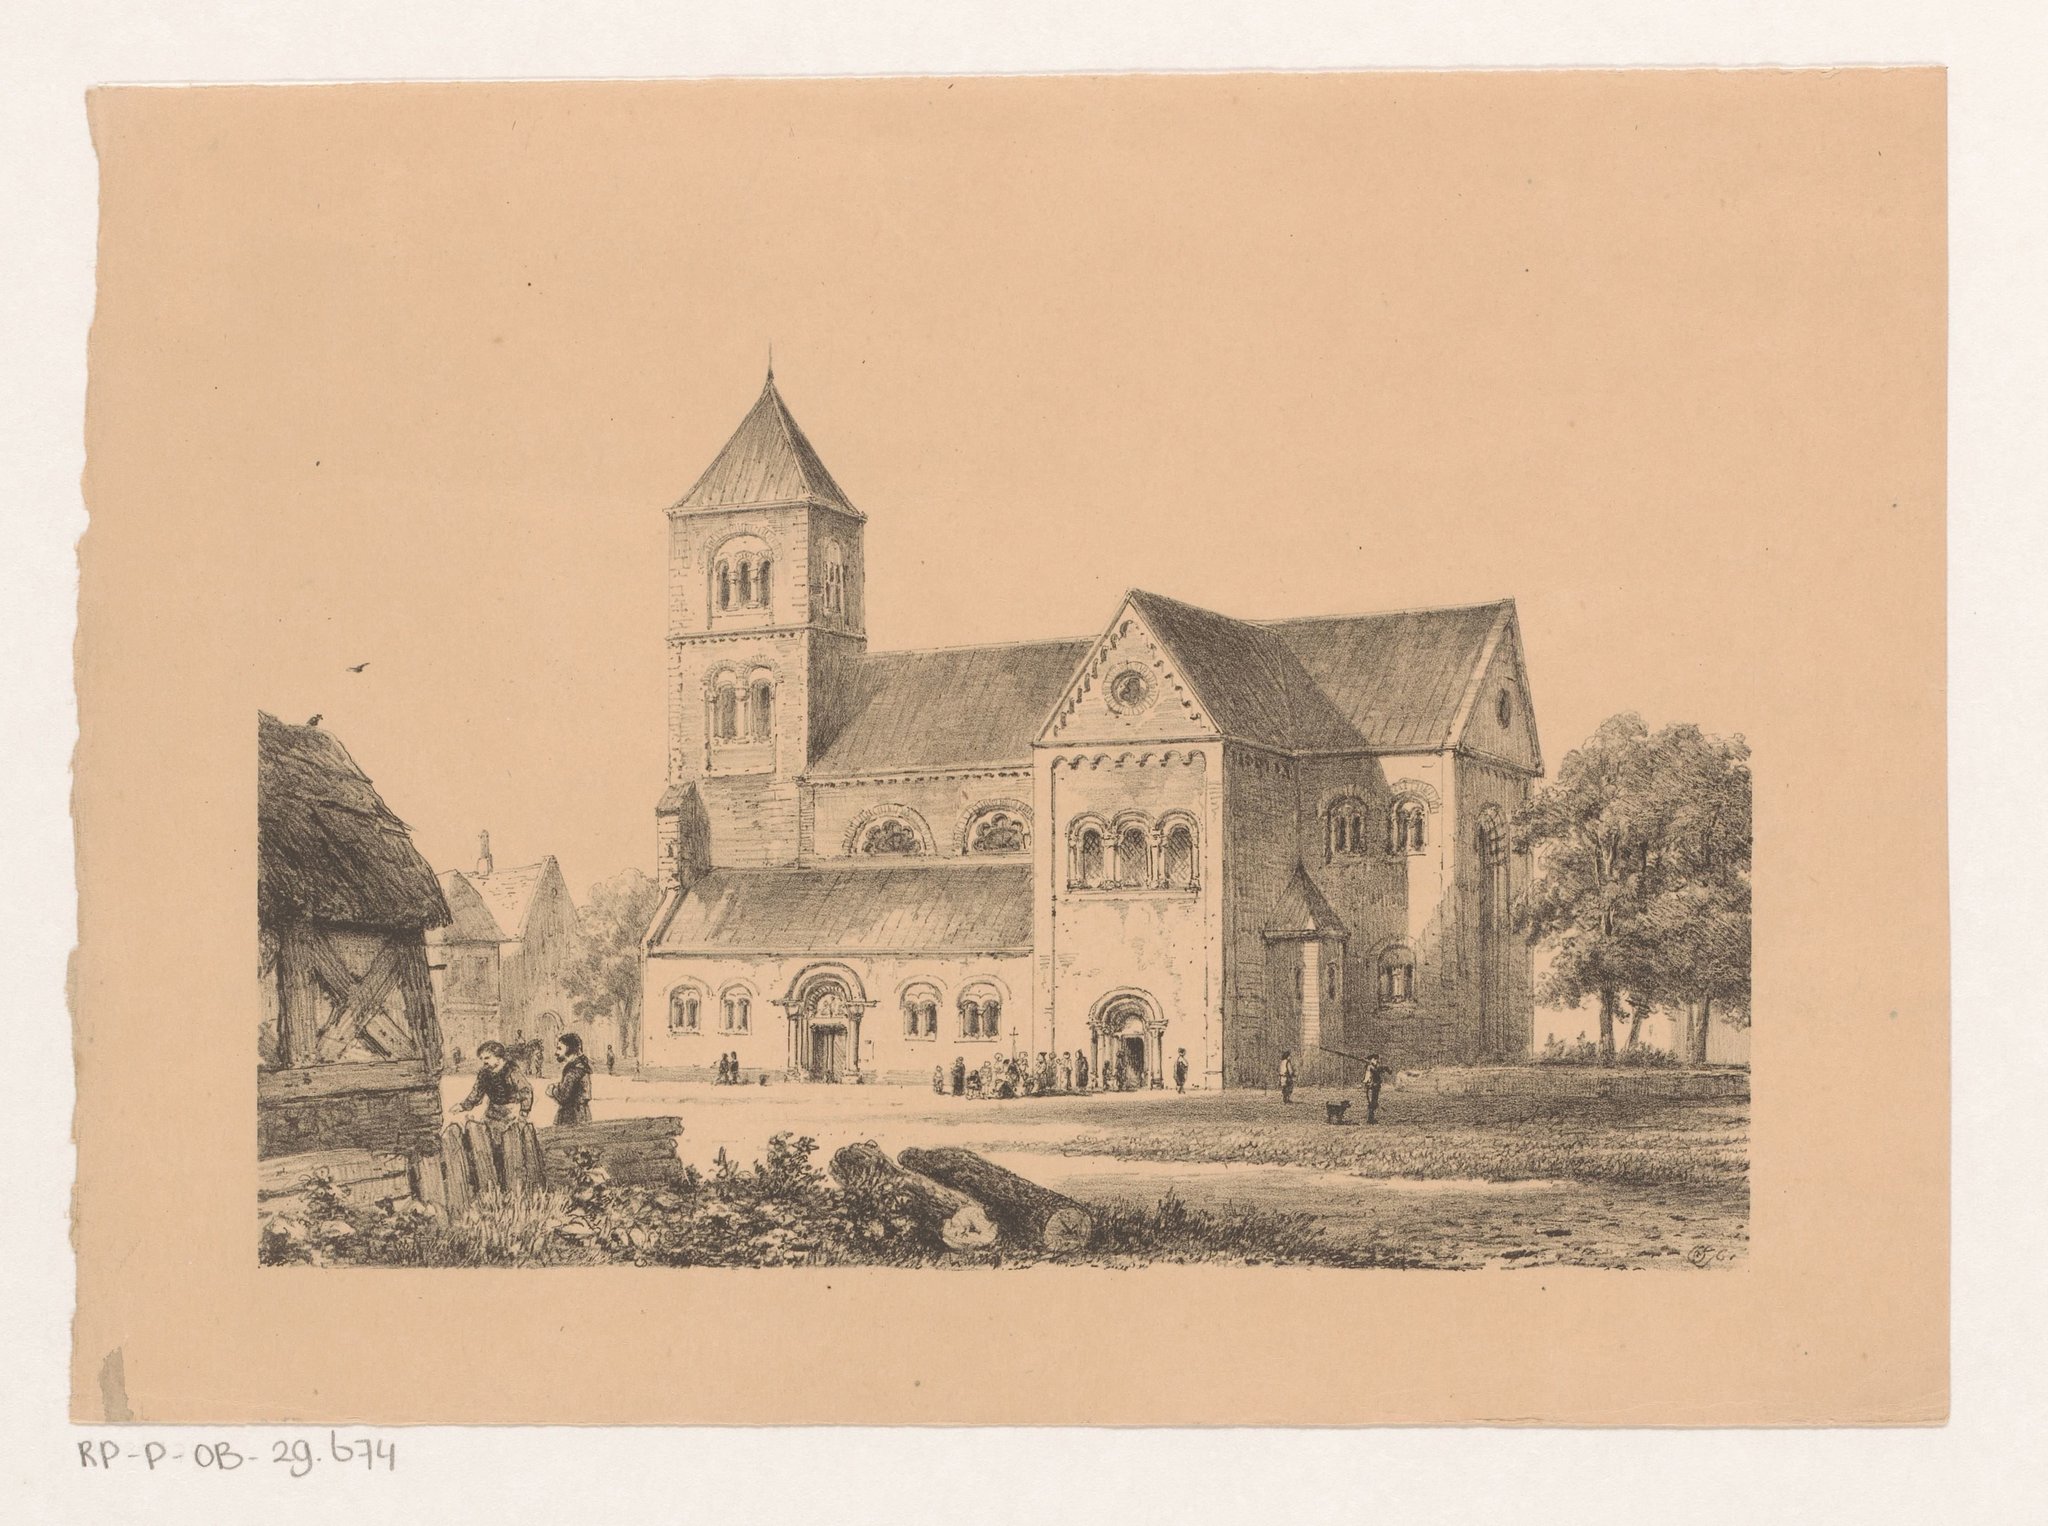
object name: book illustration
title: Kerkgebouw 12de eeuw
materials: paper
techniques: lithograph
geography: haarlem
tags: church (exterior)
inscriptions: collector's mark: Lugt 2228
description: Mensen bij de ingang van een twaalfde-eeuwse kerk. Links voor staan twee mannen bij een houten gebouw.